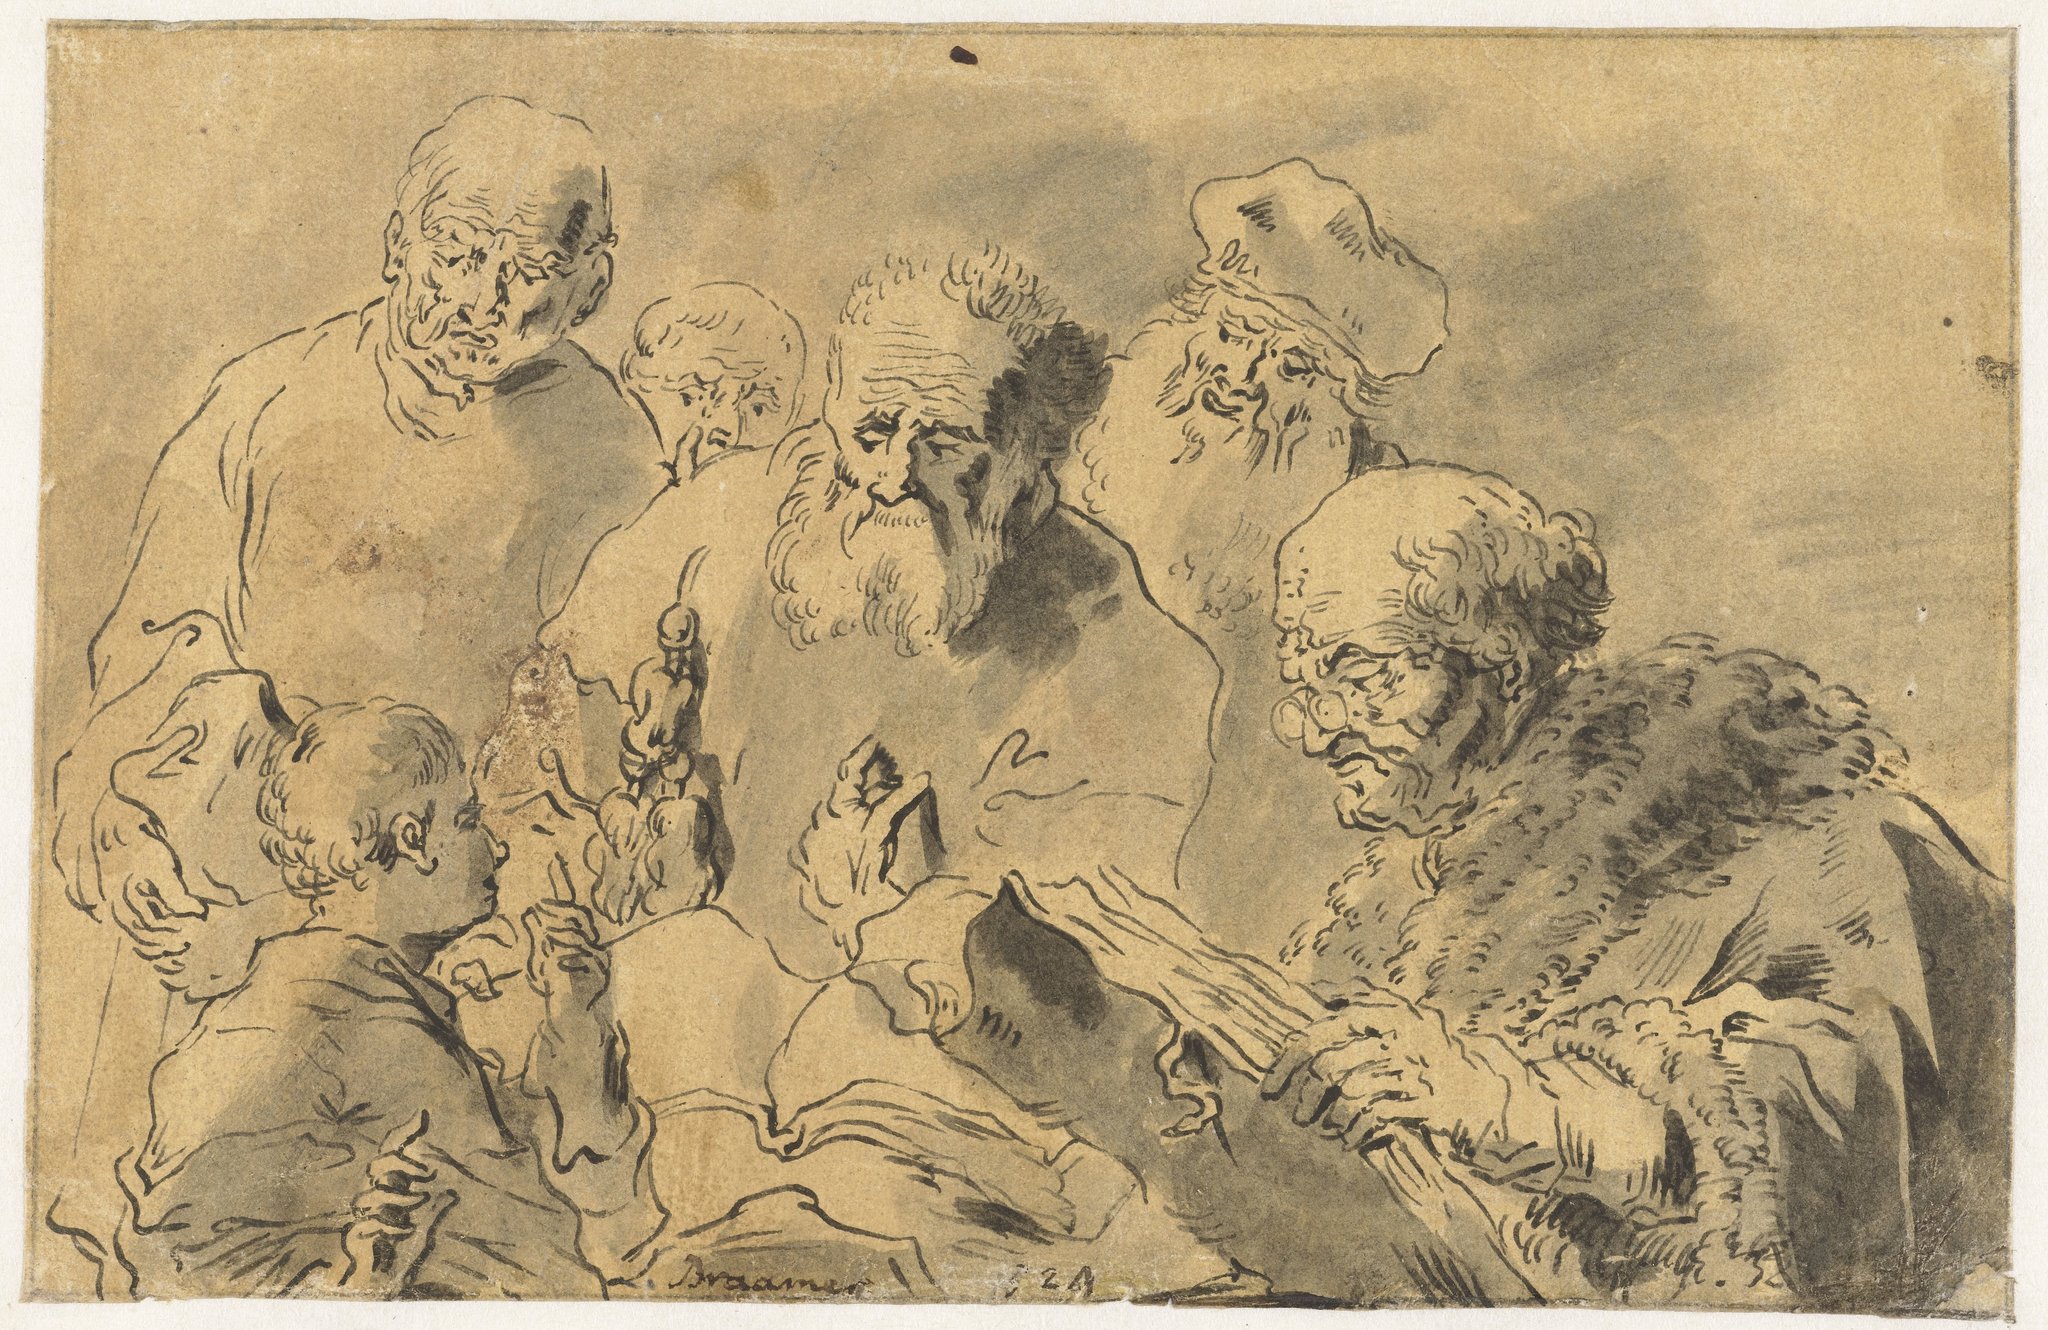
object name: drawing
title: Christus en de schriftgeleerden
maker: leonaert bramer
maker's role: draughtsman, painter, print maker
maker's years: 1596-1674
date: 1624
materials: ink, paper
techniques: brush, pen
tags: christ's dispute with the doctors in the temple; he counts his arguments on his fingers